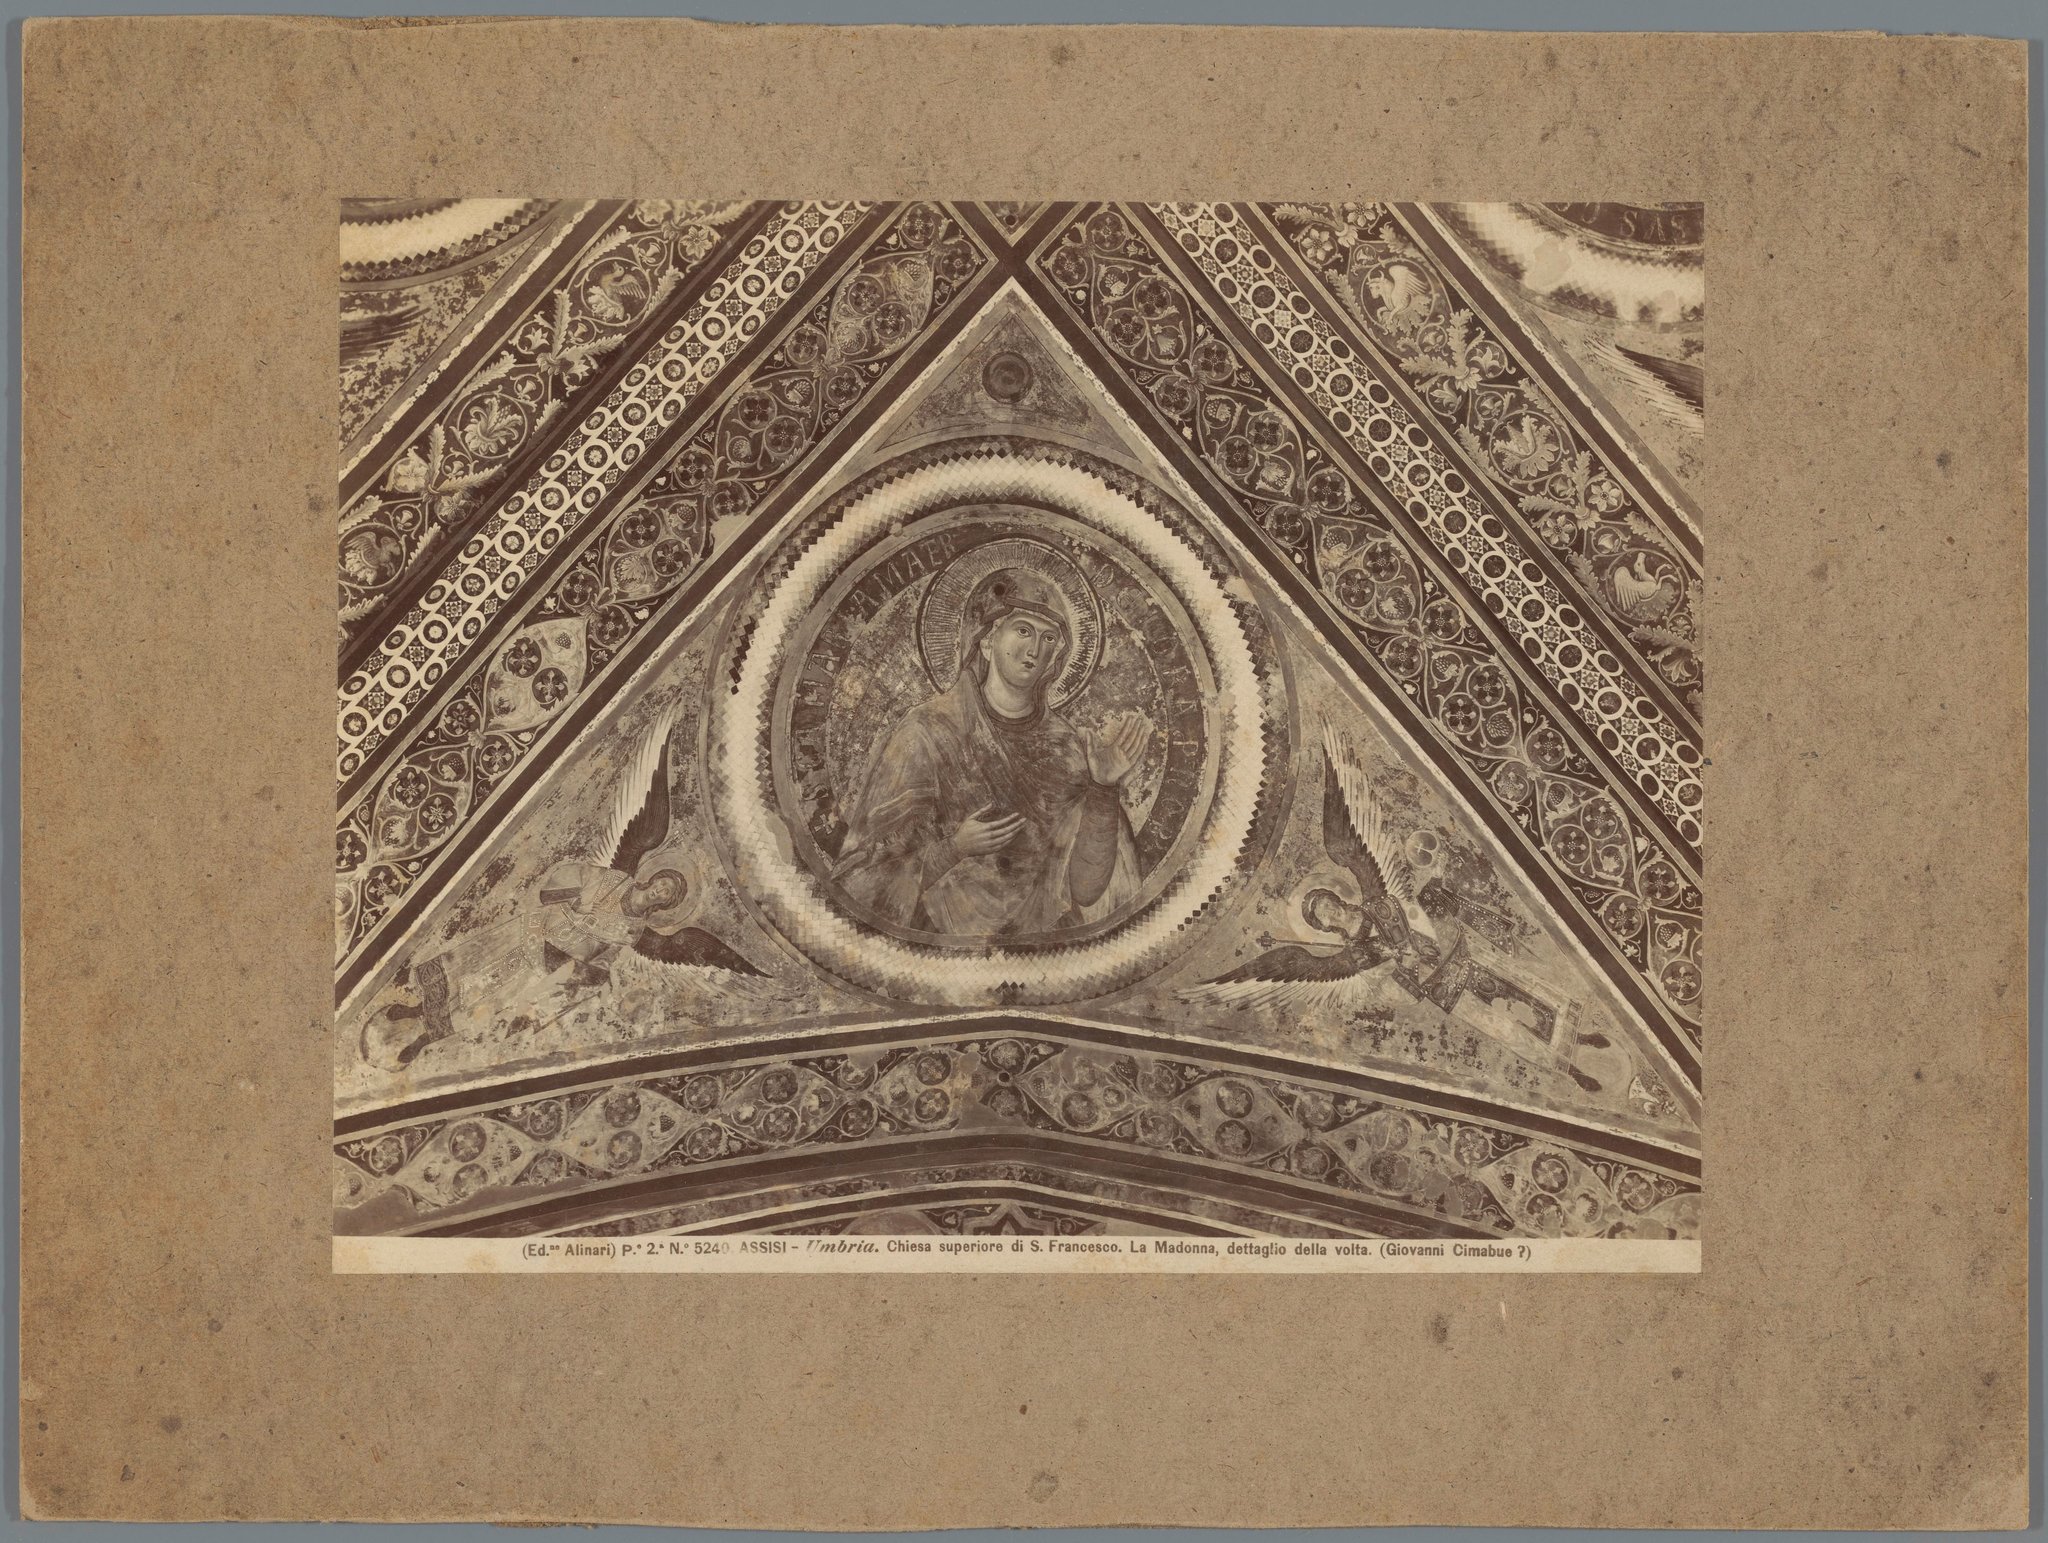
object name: photograph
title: ASSISI- Umbria. Chiesa superiore di S. Francesco. La Madonna, dettaglio della volta.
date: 1875-1900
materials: cardboard, photographic support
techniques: albumen print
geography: sint-franciscusbasiliek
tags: interior of church, 'portraits' of mary, (decorated) ceiling, angels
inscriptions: number: ‘P.e 2.a N.o 5240.’, collector's mark: Lugt 3937